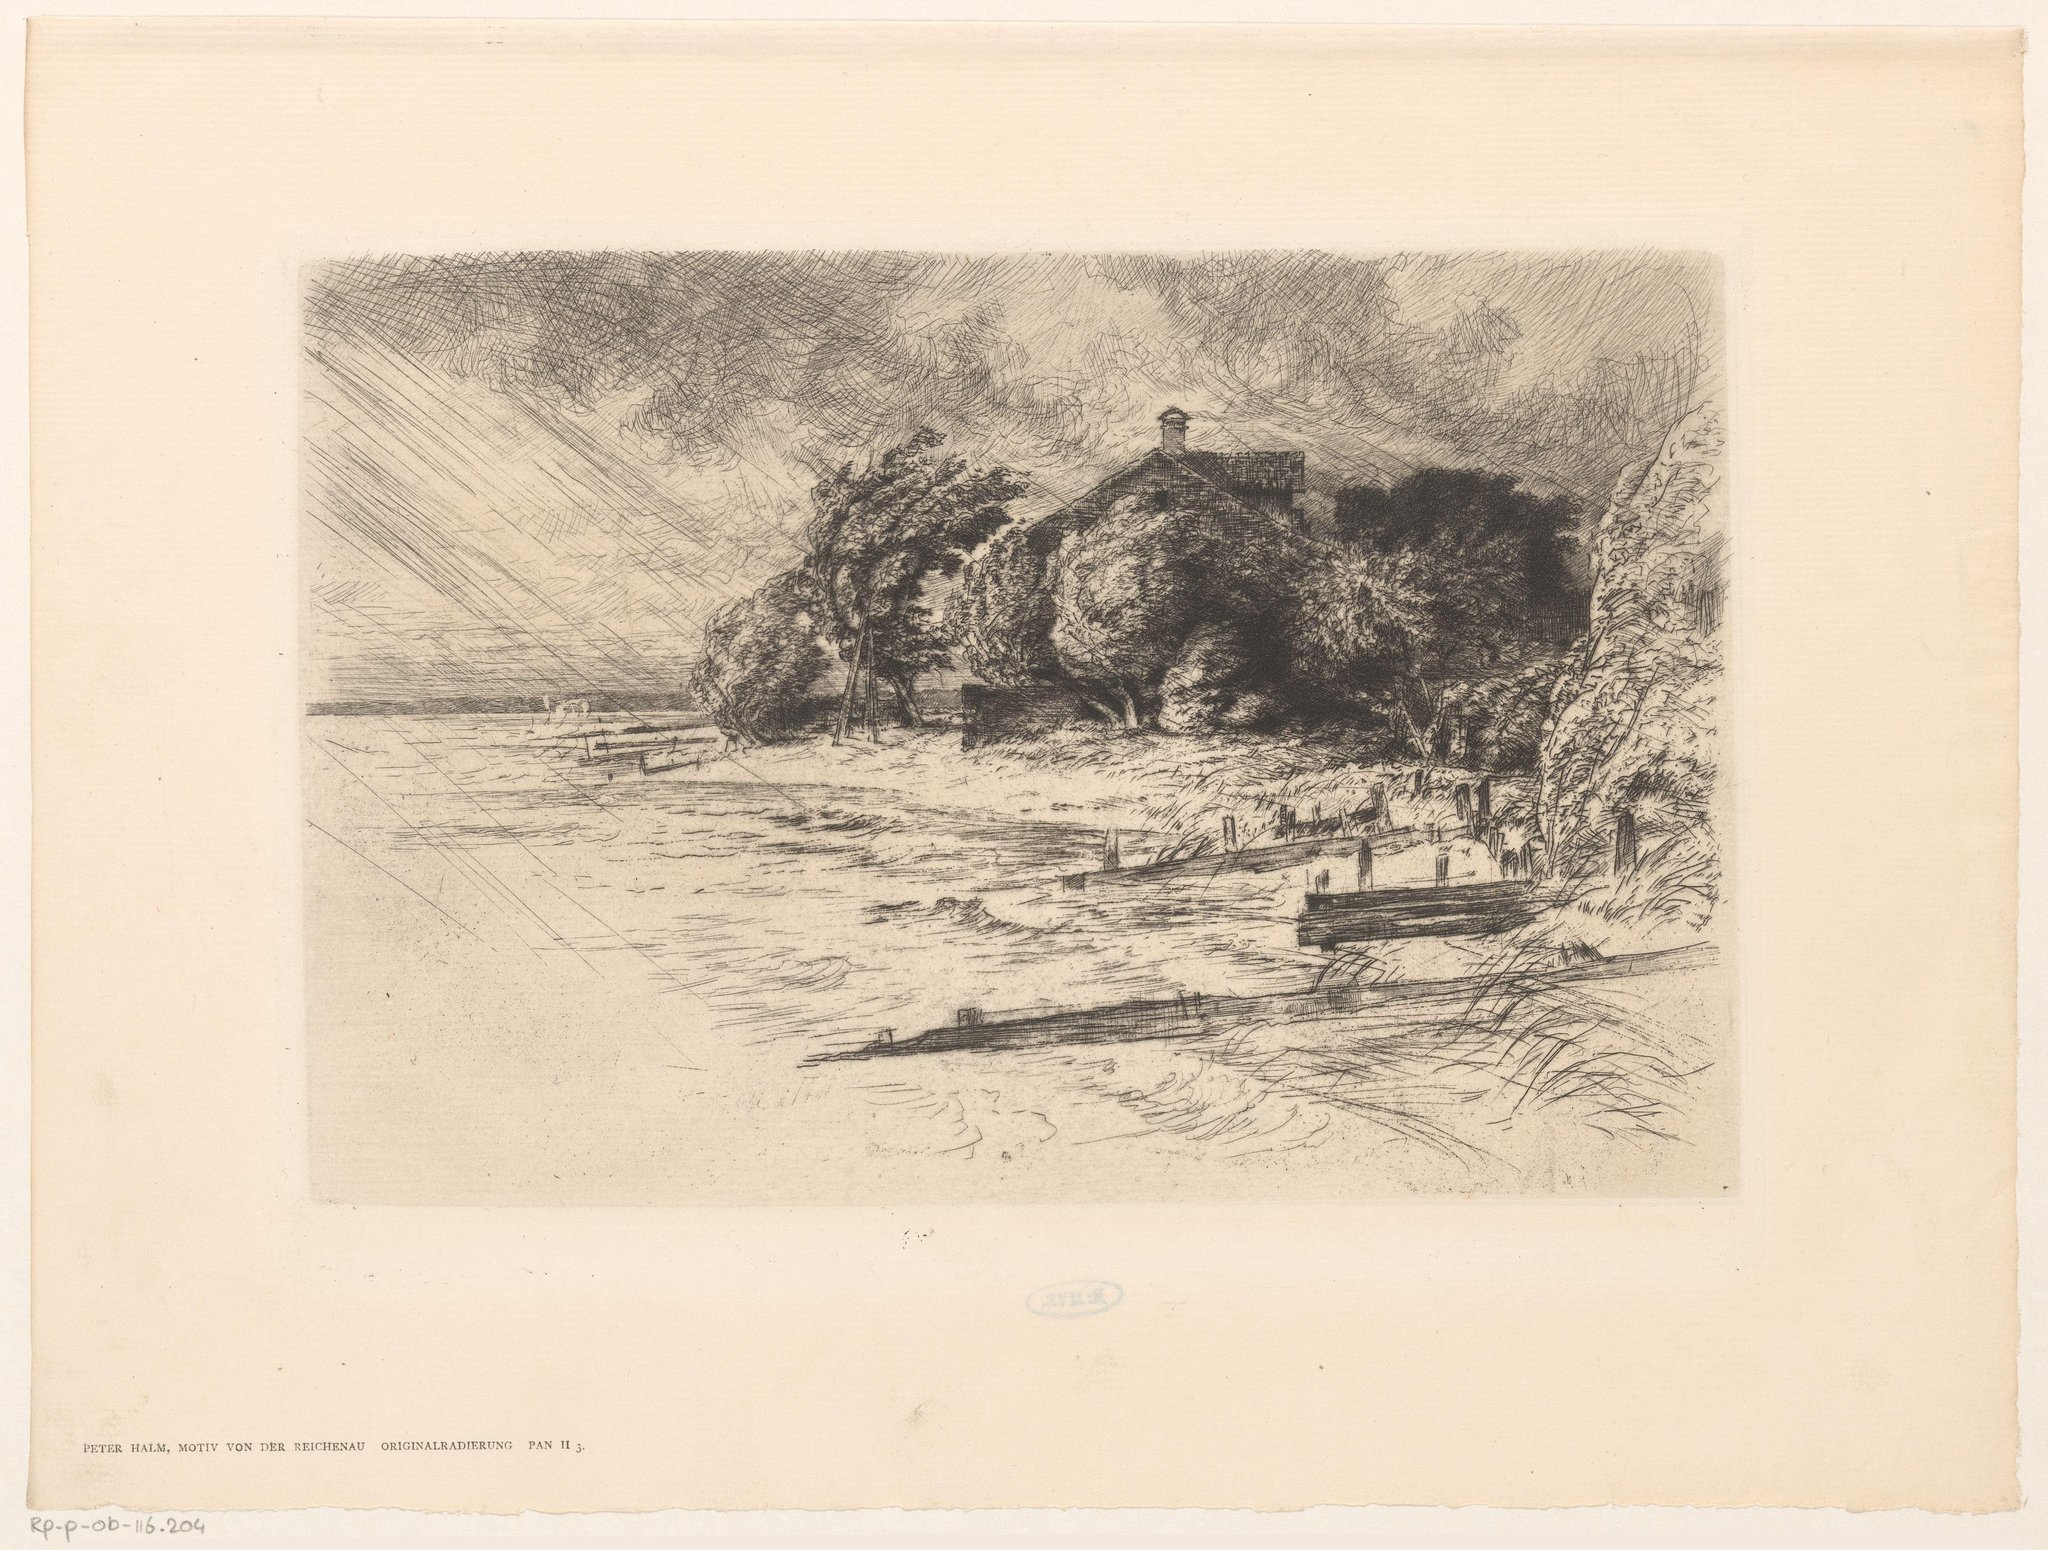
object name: print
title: Huis in stormachtig landschap in Reichenau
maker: peter von halm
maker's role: print maker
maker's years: 1854-1923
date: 1864-1923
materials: paper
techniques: drypoint, intaglio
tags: river, rural housing, e.g. country-house, villa, cottage, storm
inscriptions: collector's mark: Lugt 2228